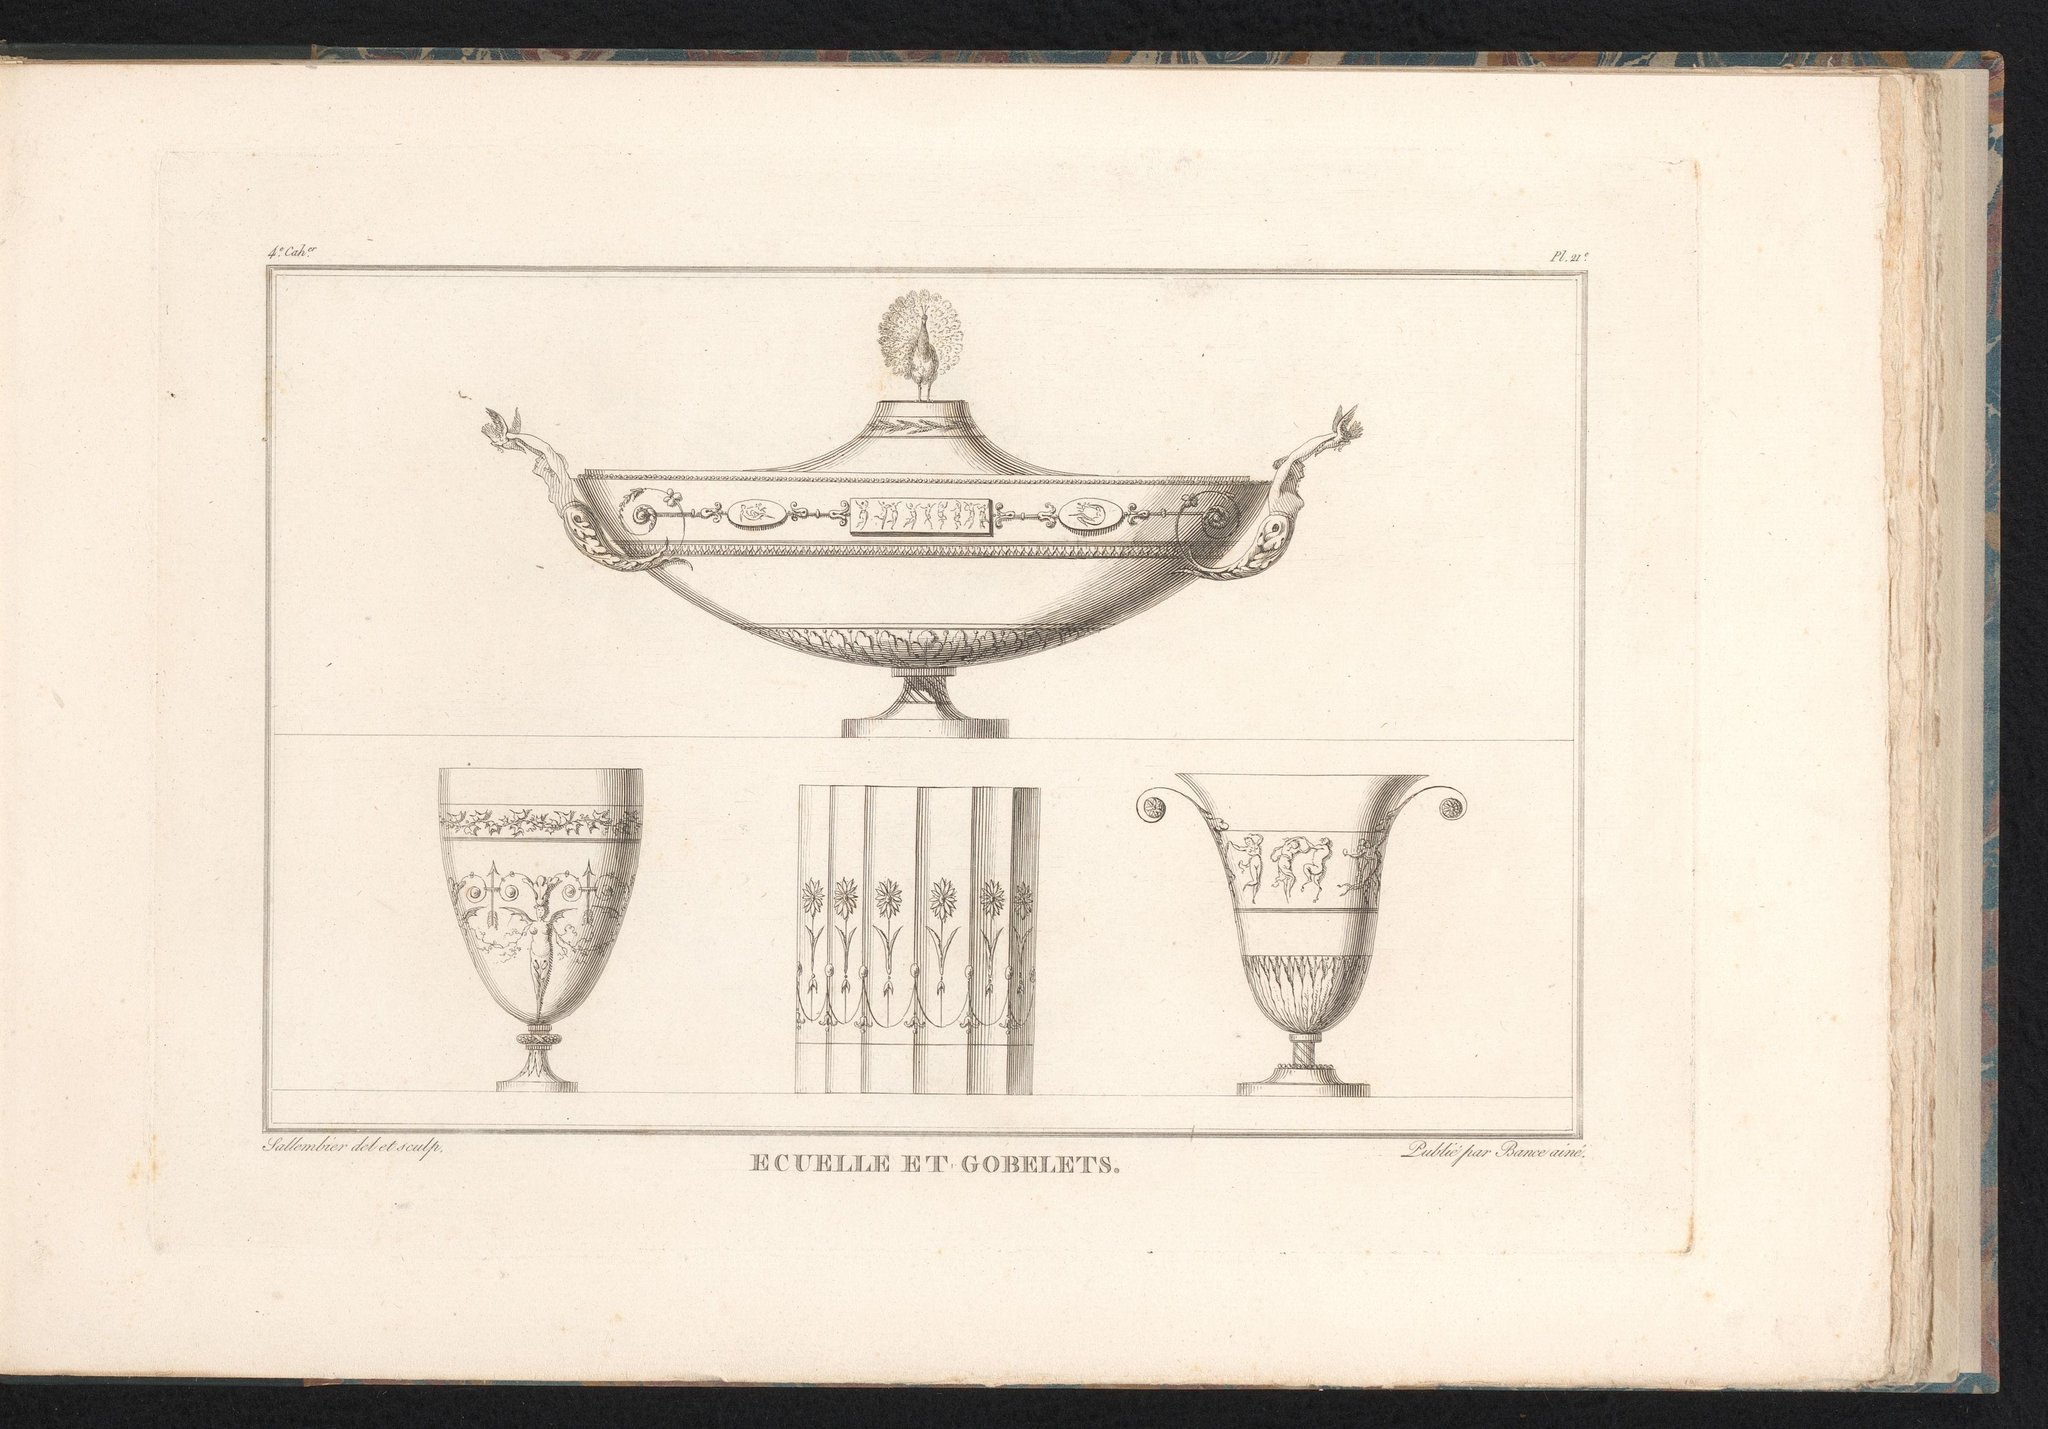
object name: ornament print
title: Ontwerpen voor edelsmeedkunst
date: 1805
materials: paper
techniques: etching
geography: paris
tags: mug, beaker, goblet, ornamental birds: peacock, bowl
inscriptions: number: ‘4.e Cah.er’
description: Ontwerpen voor een schaal met een pauw en drie bokalen. Prent maakt deel uit van een album.